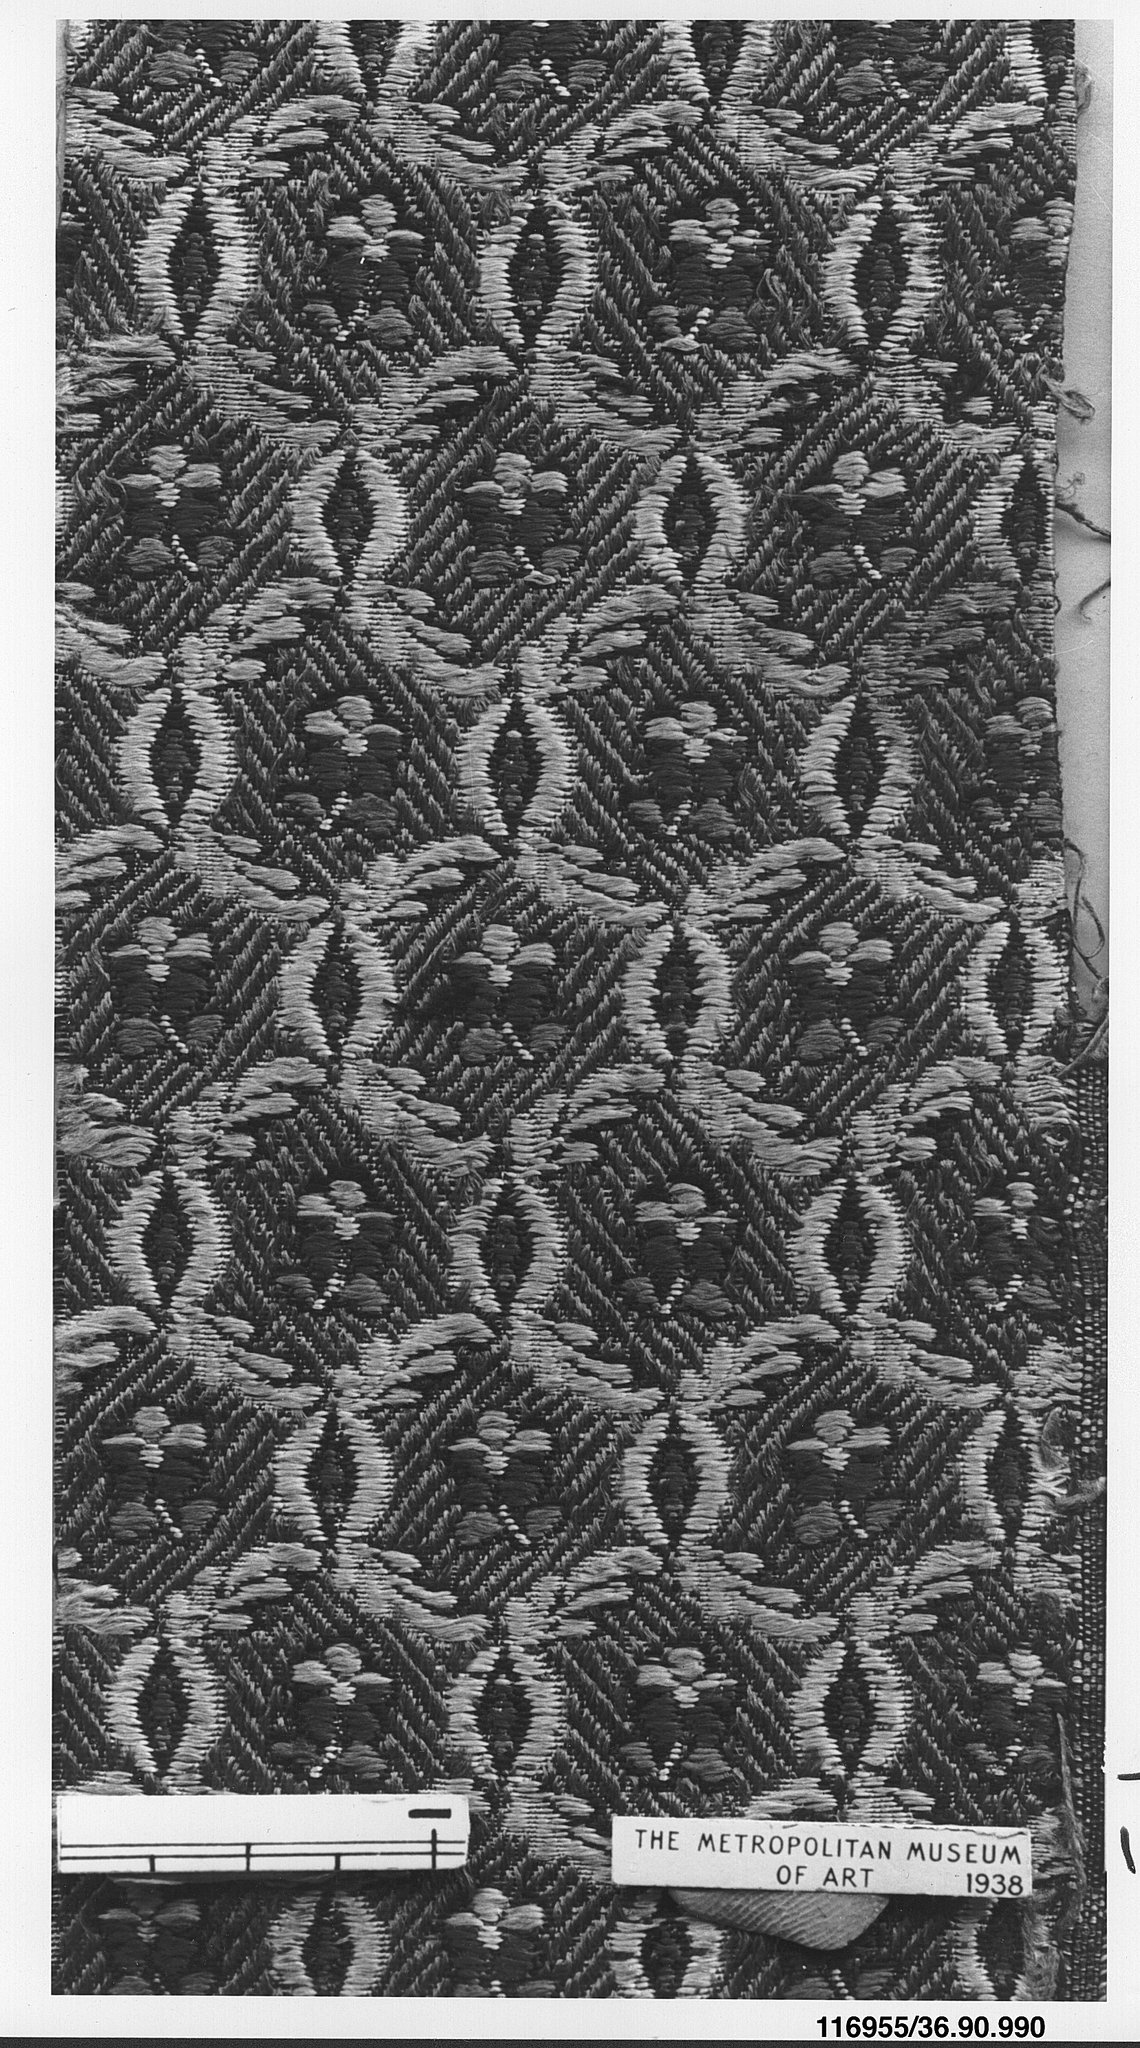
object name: piece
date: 1701-1800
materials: silk